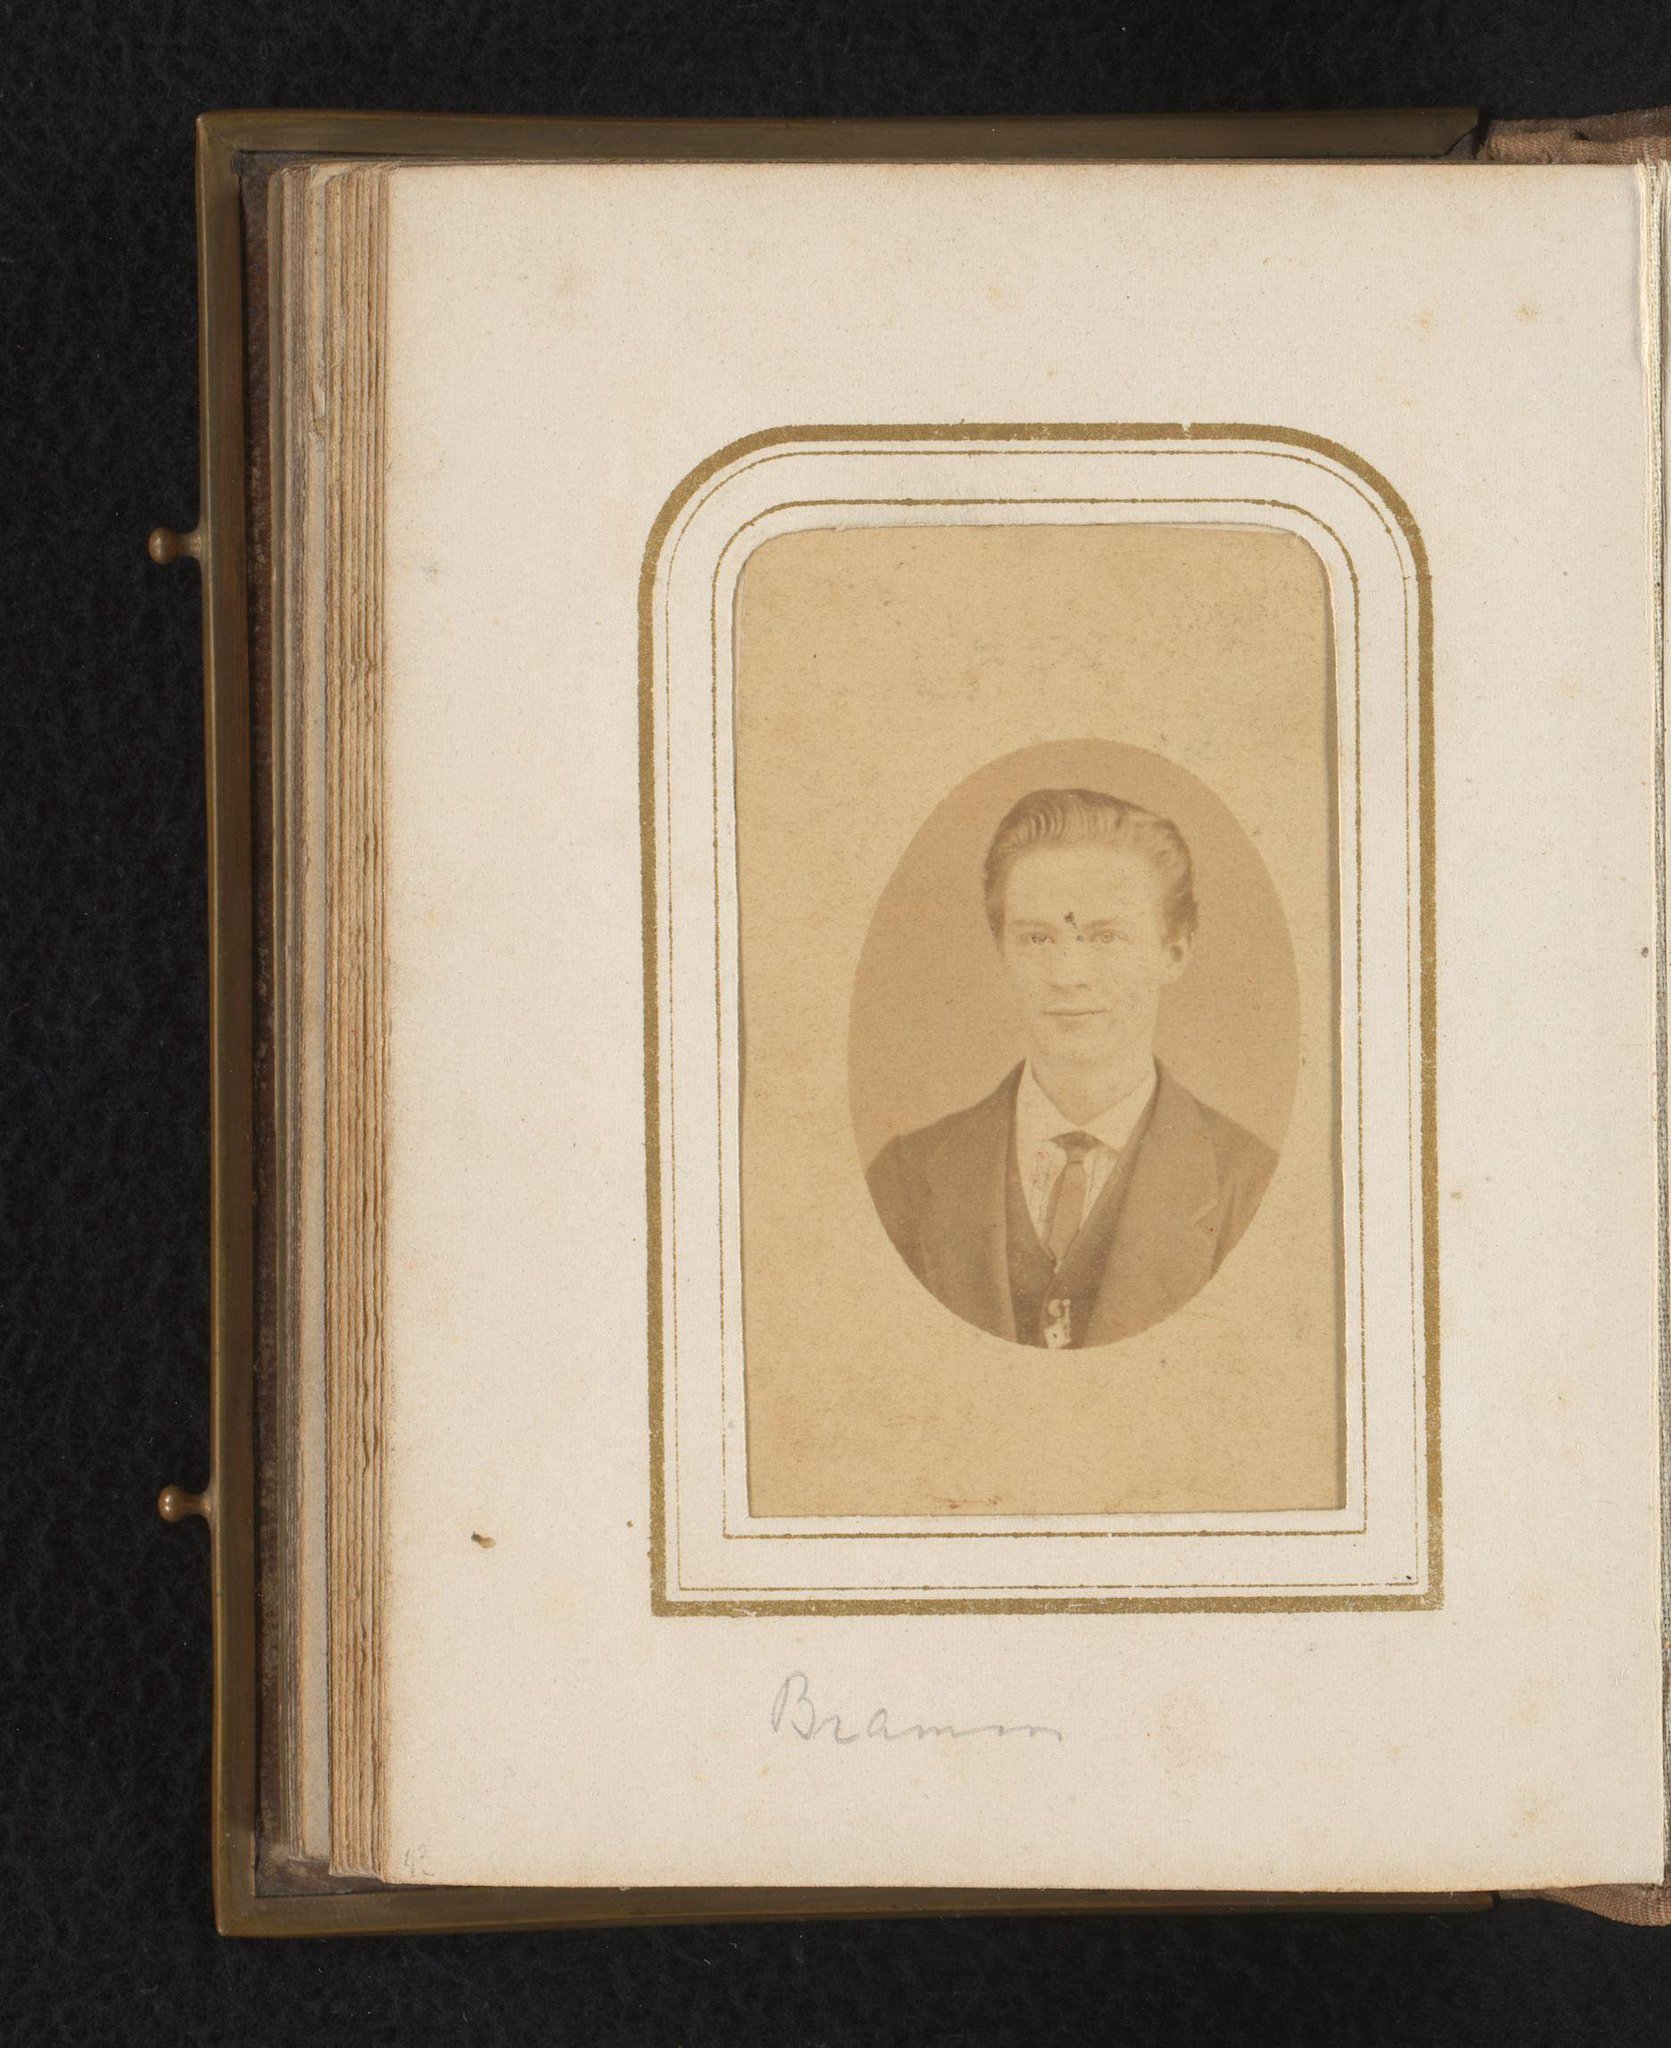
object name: carte de visite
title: Portret van een man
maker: Anonymous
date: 1860-1900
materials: cardboard, photographic support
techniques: albumen print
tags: adult man, historical persons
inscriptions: annotation: ‘G. L. B[...]’